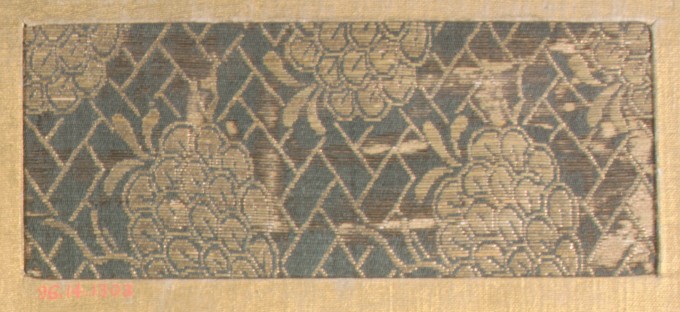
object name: piece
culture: japanese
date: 1701-1900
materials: silk